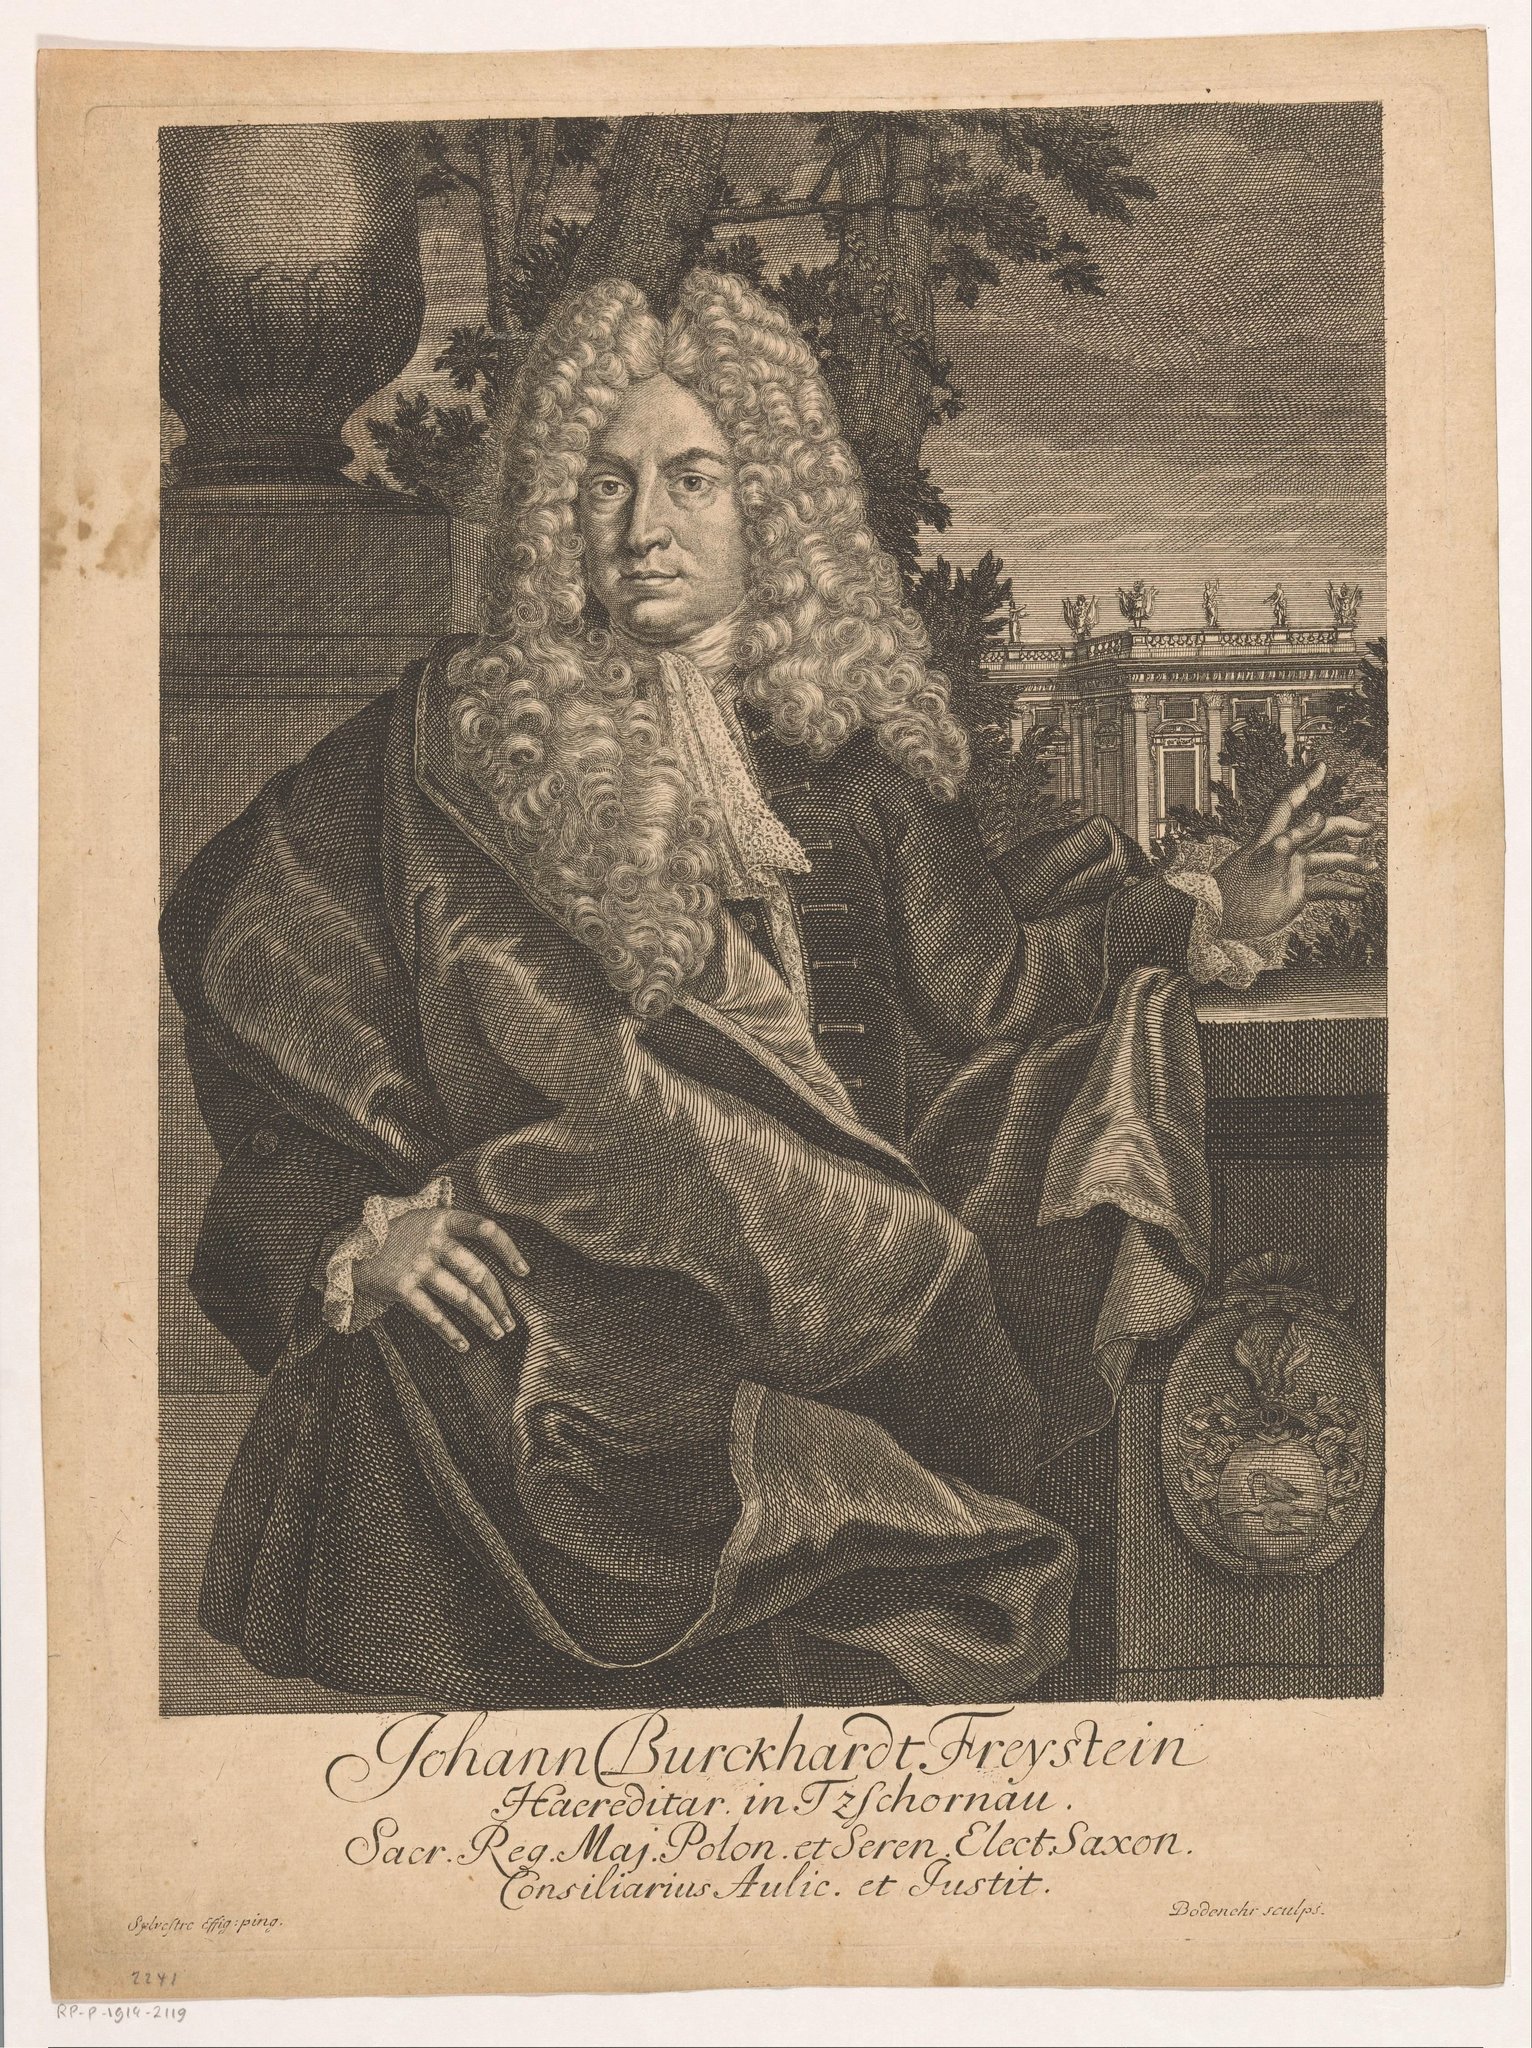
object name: print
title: Portret van Johann Burkhard Freystein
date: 1675-1748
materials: paper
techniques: engraving, etching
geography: dresden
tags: historical persons, palace, armorial bearing, heraldry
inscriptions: collector's mark: Lugt 2228